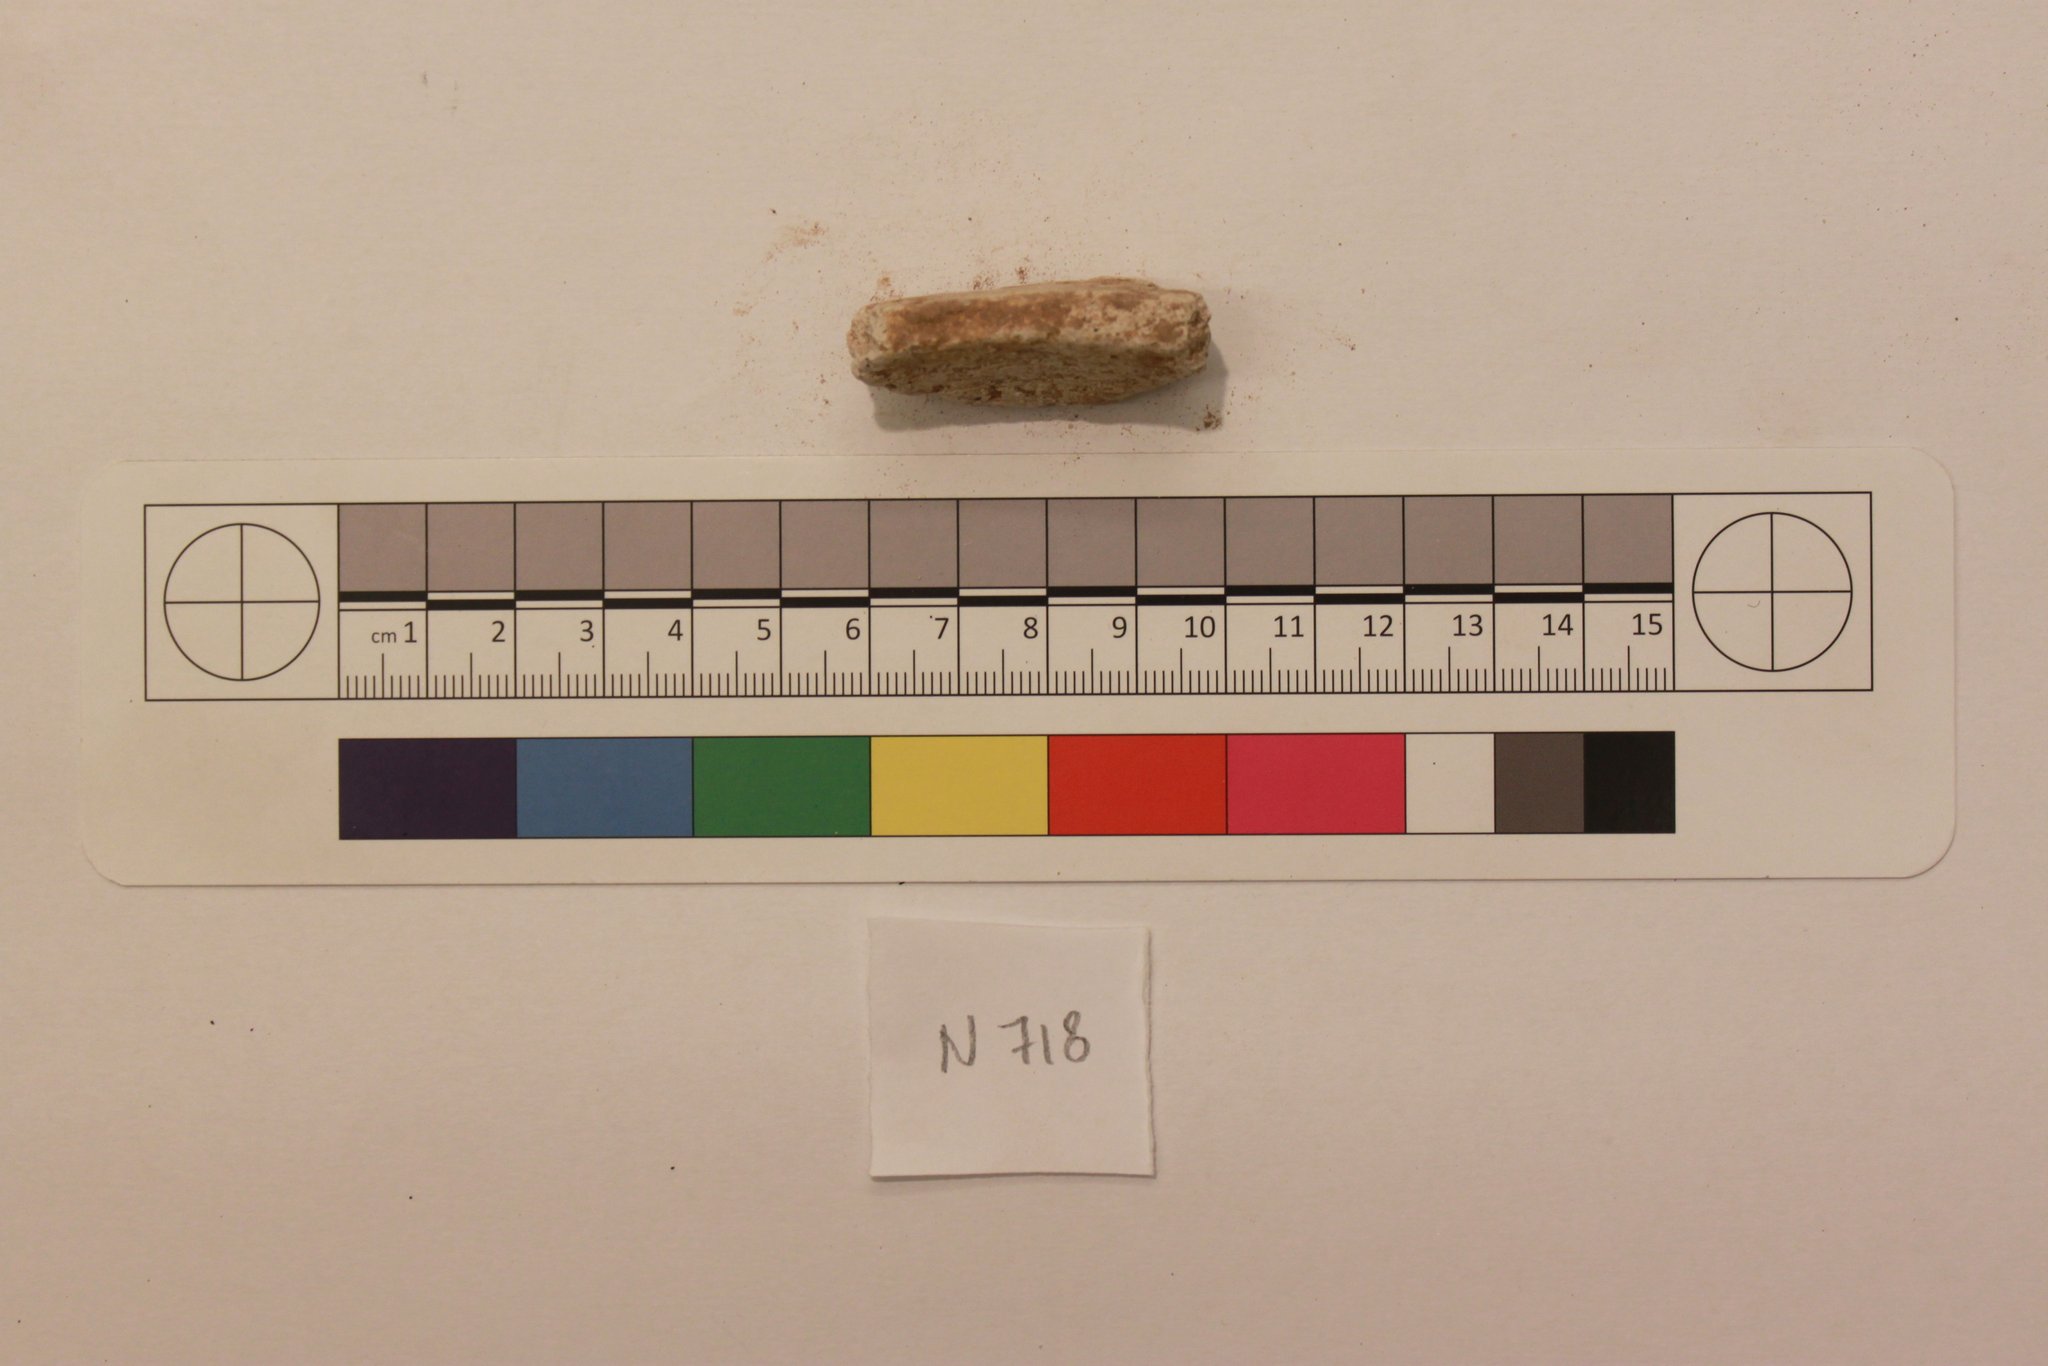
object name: fragment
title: Stucco Fragment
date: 701-1200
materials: plaster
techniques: carving, painting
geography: iran